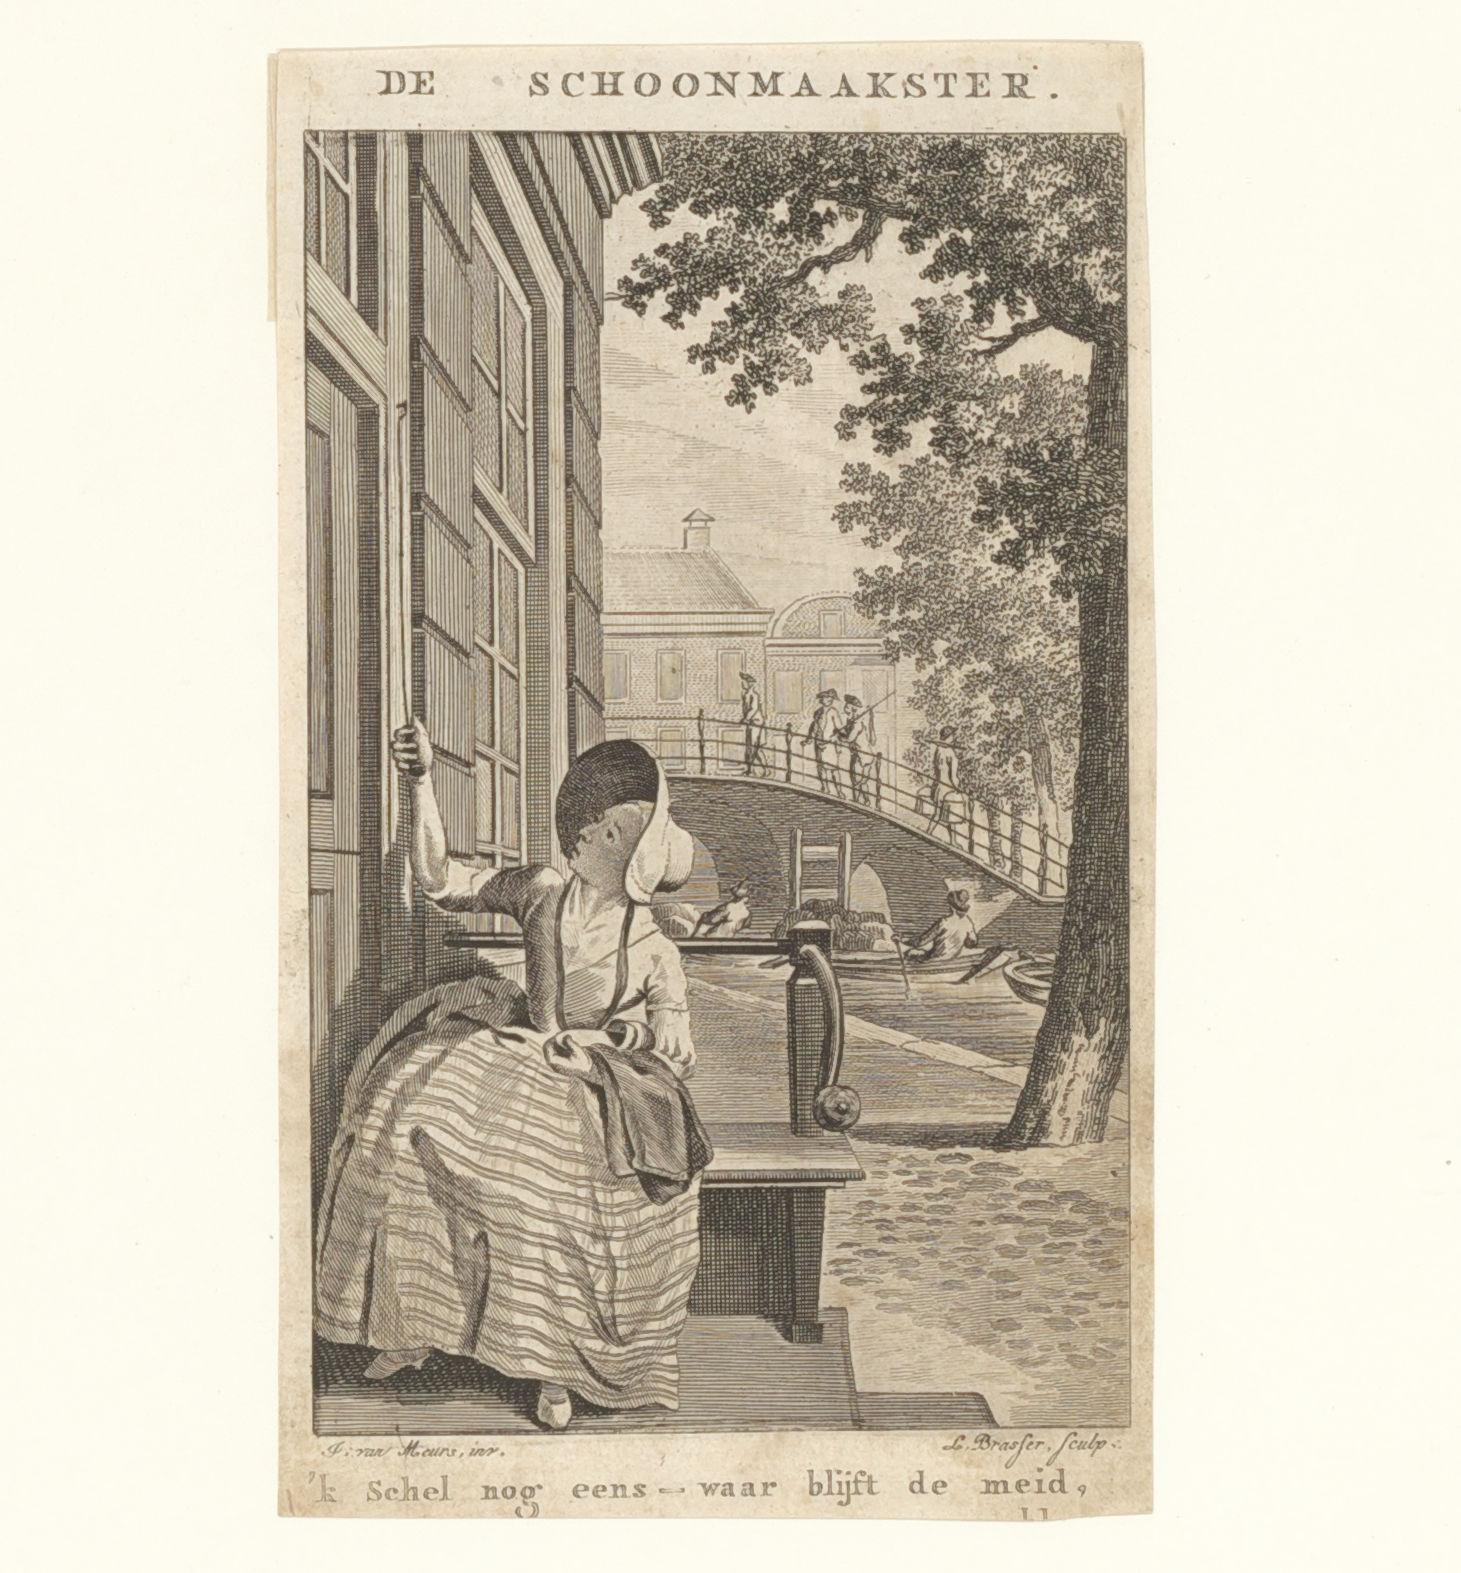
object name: print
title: De schoonmaakster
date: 1789-1791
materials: paper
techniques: engraving, etching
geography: netherlands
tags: door-knocker, doorbell, charwoman, cleaning woman, maid ~ house personnel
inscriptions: collector's mark: Lugt 1641, collector's mark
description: Gebruikt als illustratie in: Volks-liedjes, uitgegeven door de Maatschappij tot Nut van 't Algemeen, Amsterdam: Harmanus Keijzer, Arend Fokke en Cornelis de Vries, 3 delen, 1789-1791, p. 44.